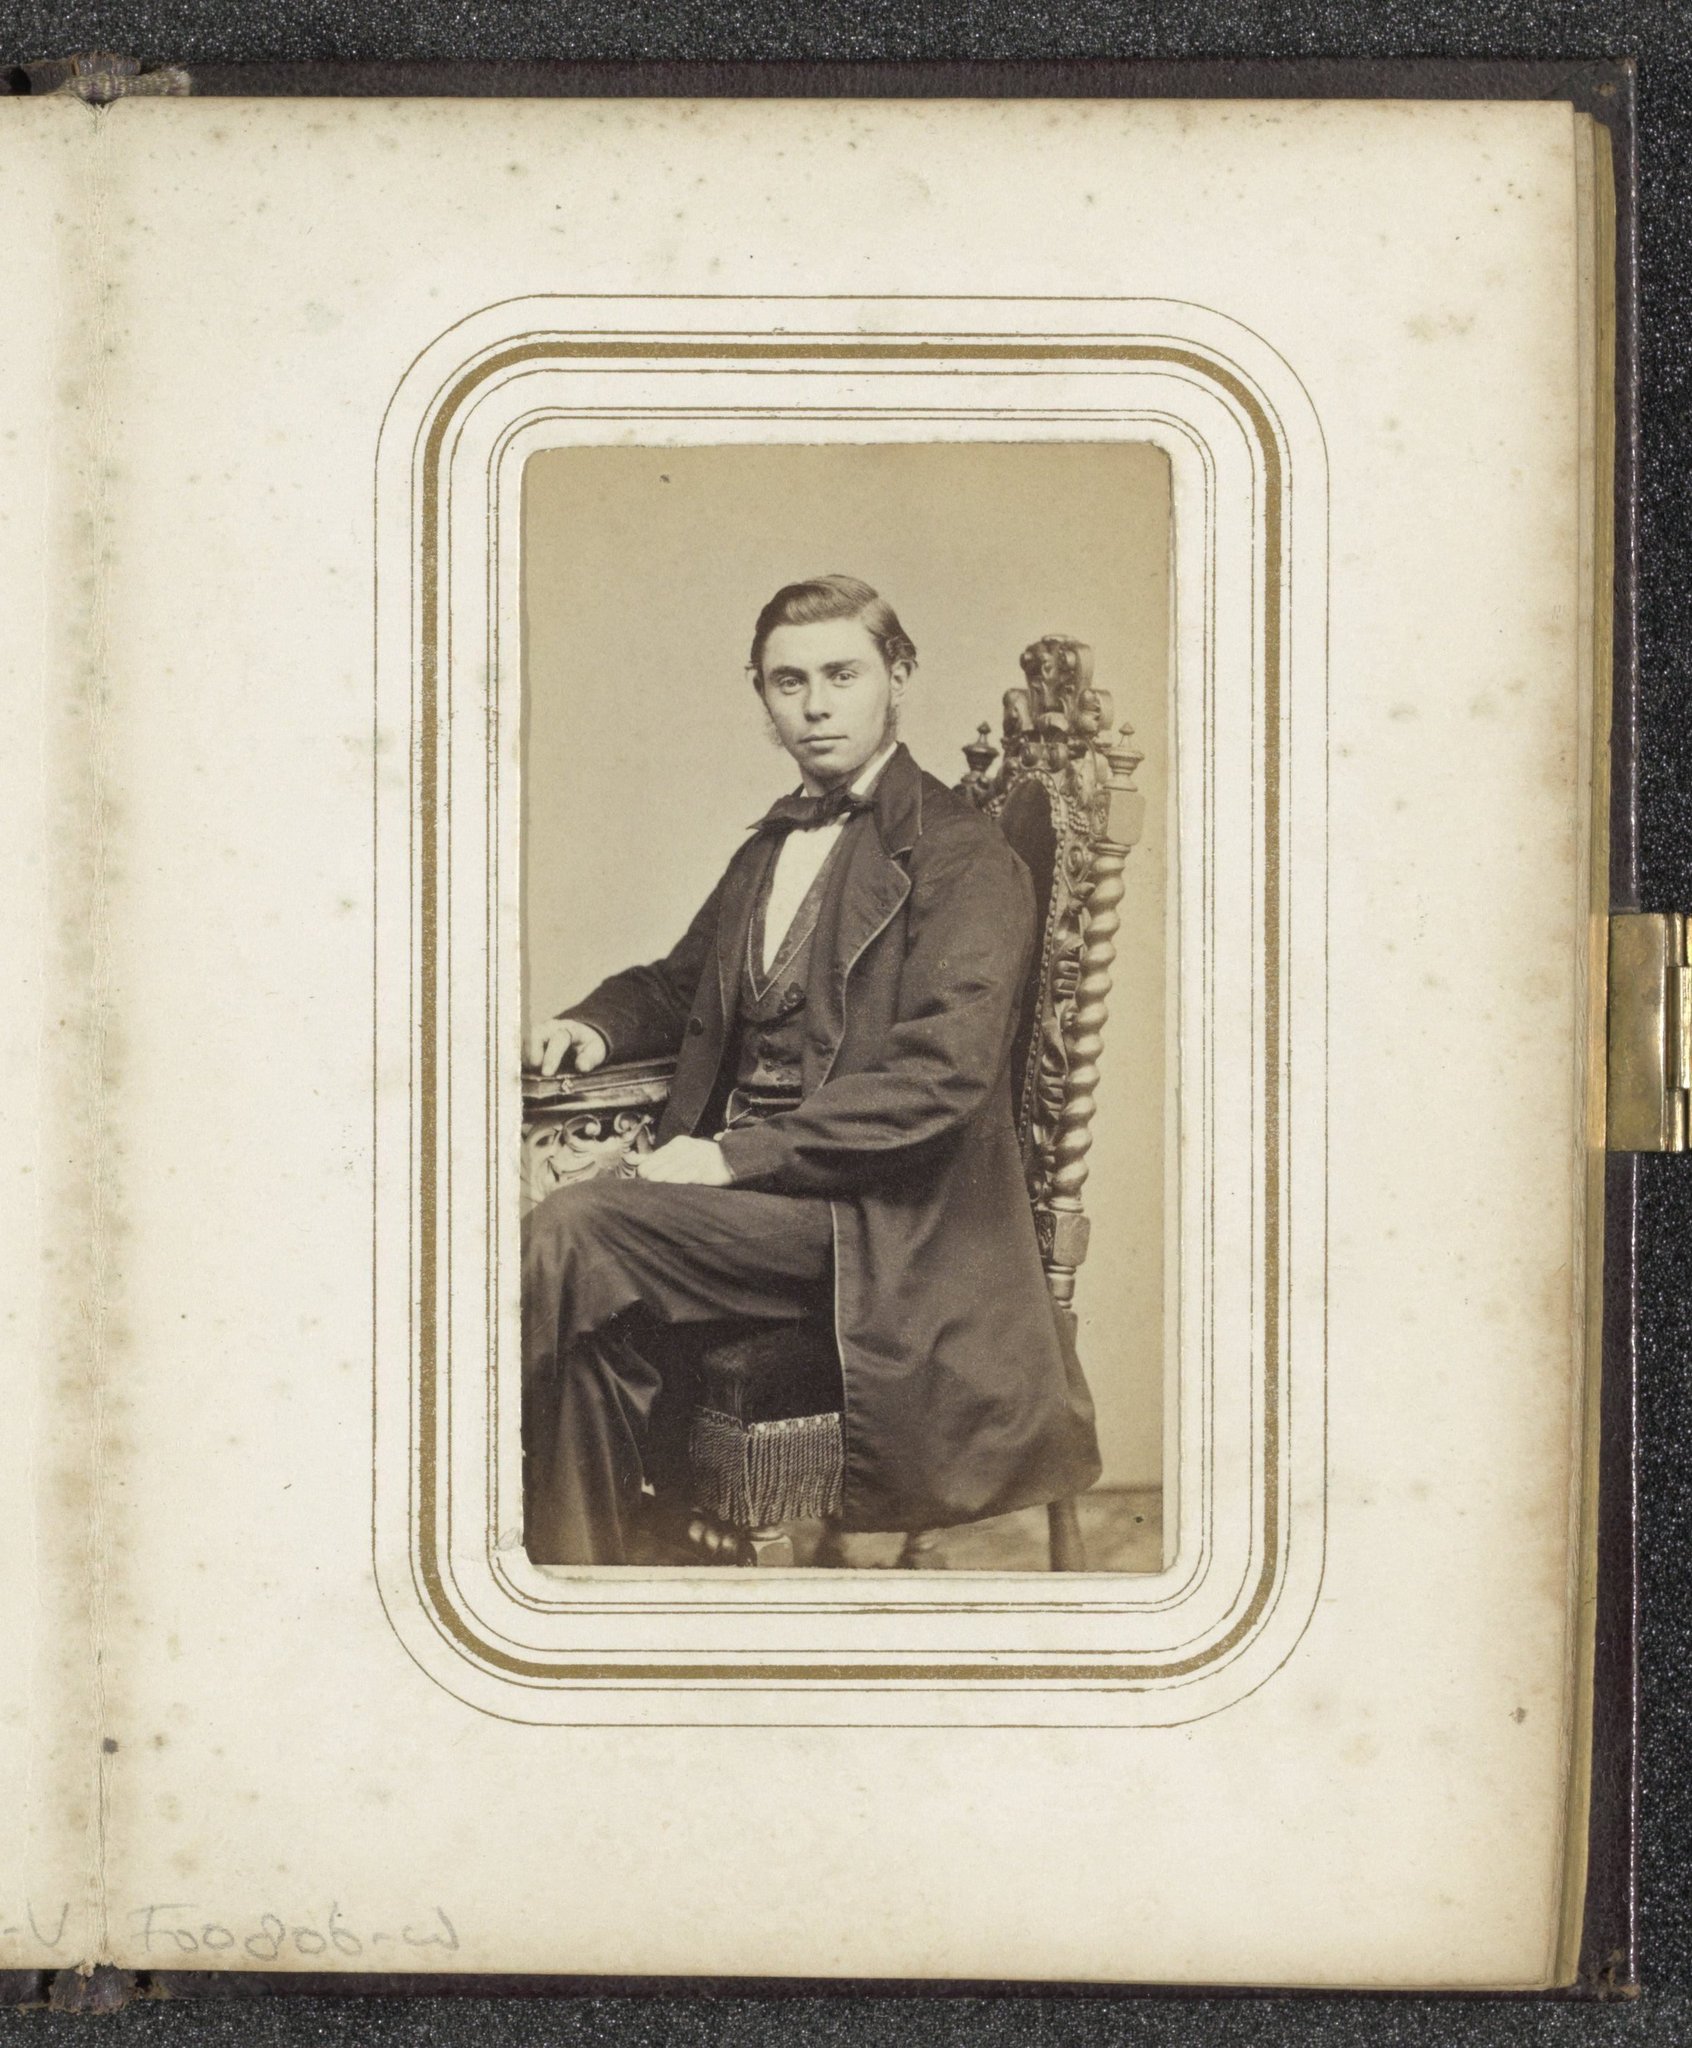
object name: carte de visite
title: Portret van een jongeman met bakkebaarden zittend bij een tafel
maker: peter carstensen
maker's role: fotograaf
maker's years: 1817-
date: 1854-1868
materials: cardboard, paper, photographic support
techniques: albumen print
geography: amsterdam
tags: sideburns, studio requisites ~ photographer, trousers, breeches, historical persons, neck-gear ~ clothing, hairdress, coat, cape, amsterdam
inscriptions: address: ‘Amsterdam Nieuwendyk H. 201.’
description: Onderdeel van Fotoalbum met 36 cartes-de-visite van Nederlandse personen.